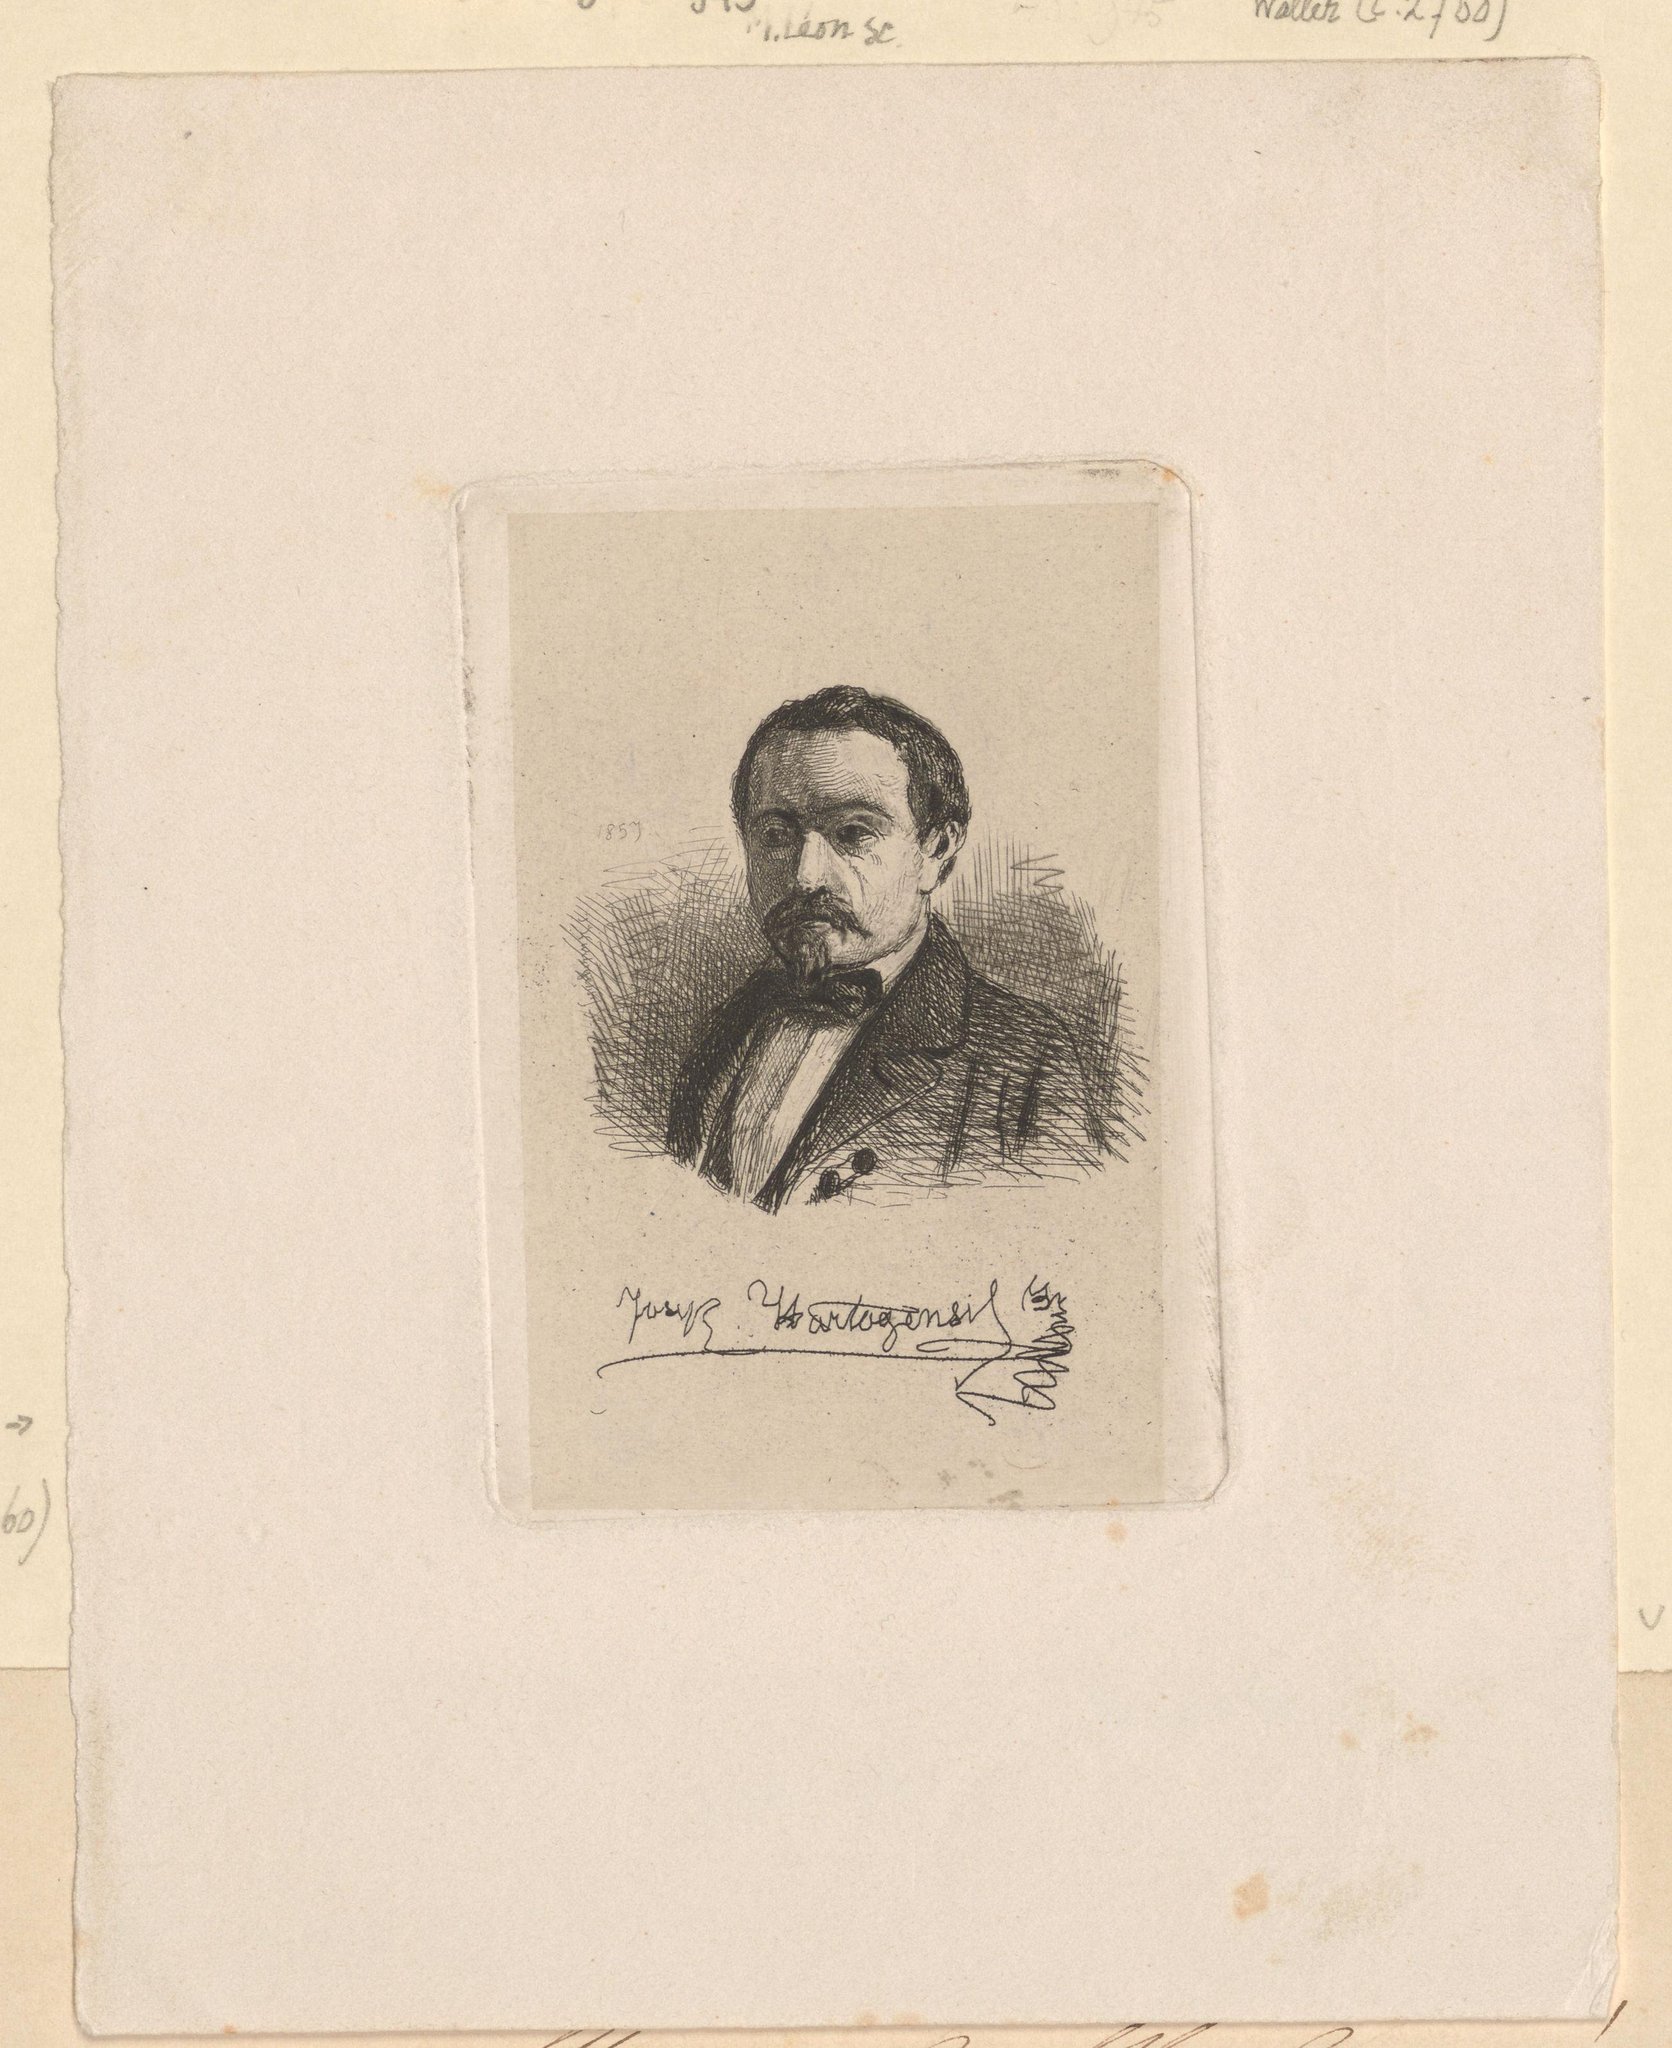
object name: print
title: Zelfportret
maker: joseph hartogensis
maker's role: painter, print maker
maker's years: 1822-1865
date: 1857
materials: paper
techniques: etching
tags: den bosch, painter, print maker, joseph hartogensis, historical persons, portrait, self-portrait of artist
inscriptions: collector's mark: Lugt 2760, collector's mark: Lugt 2228